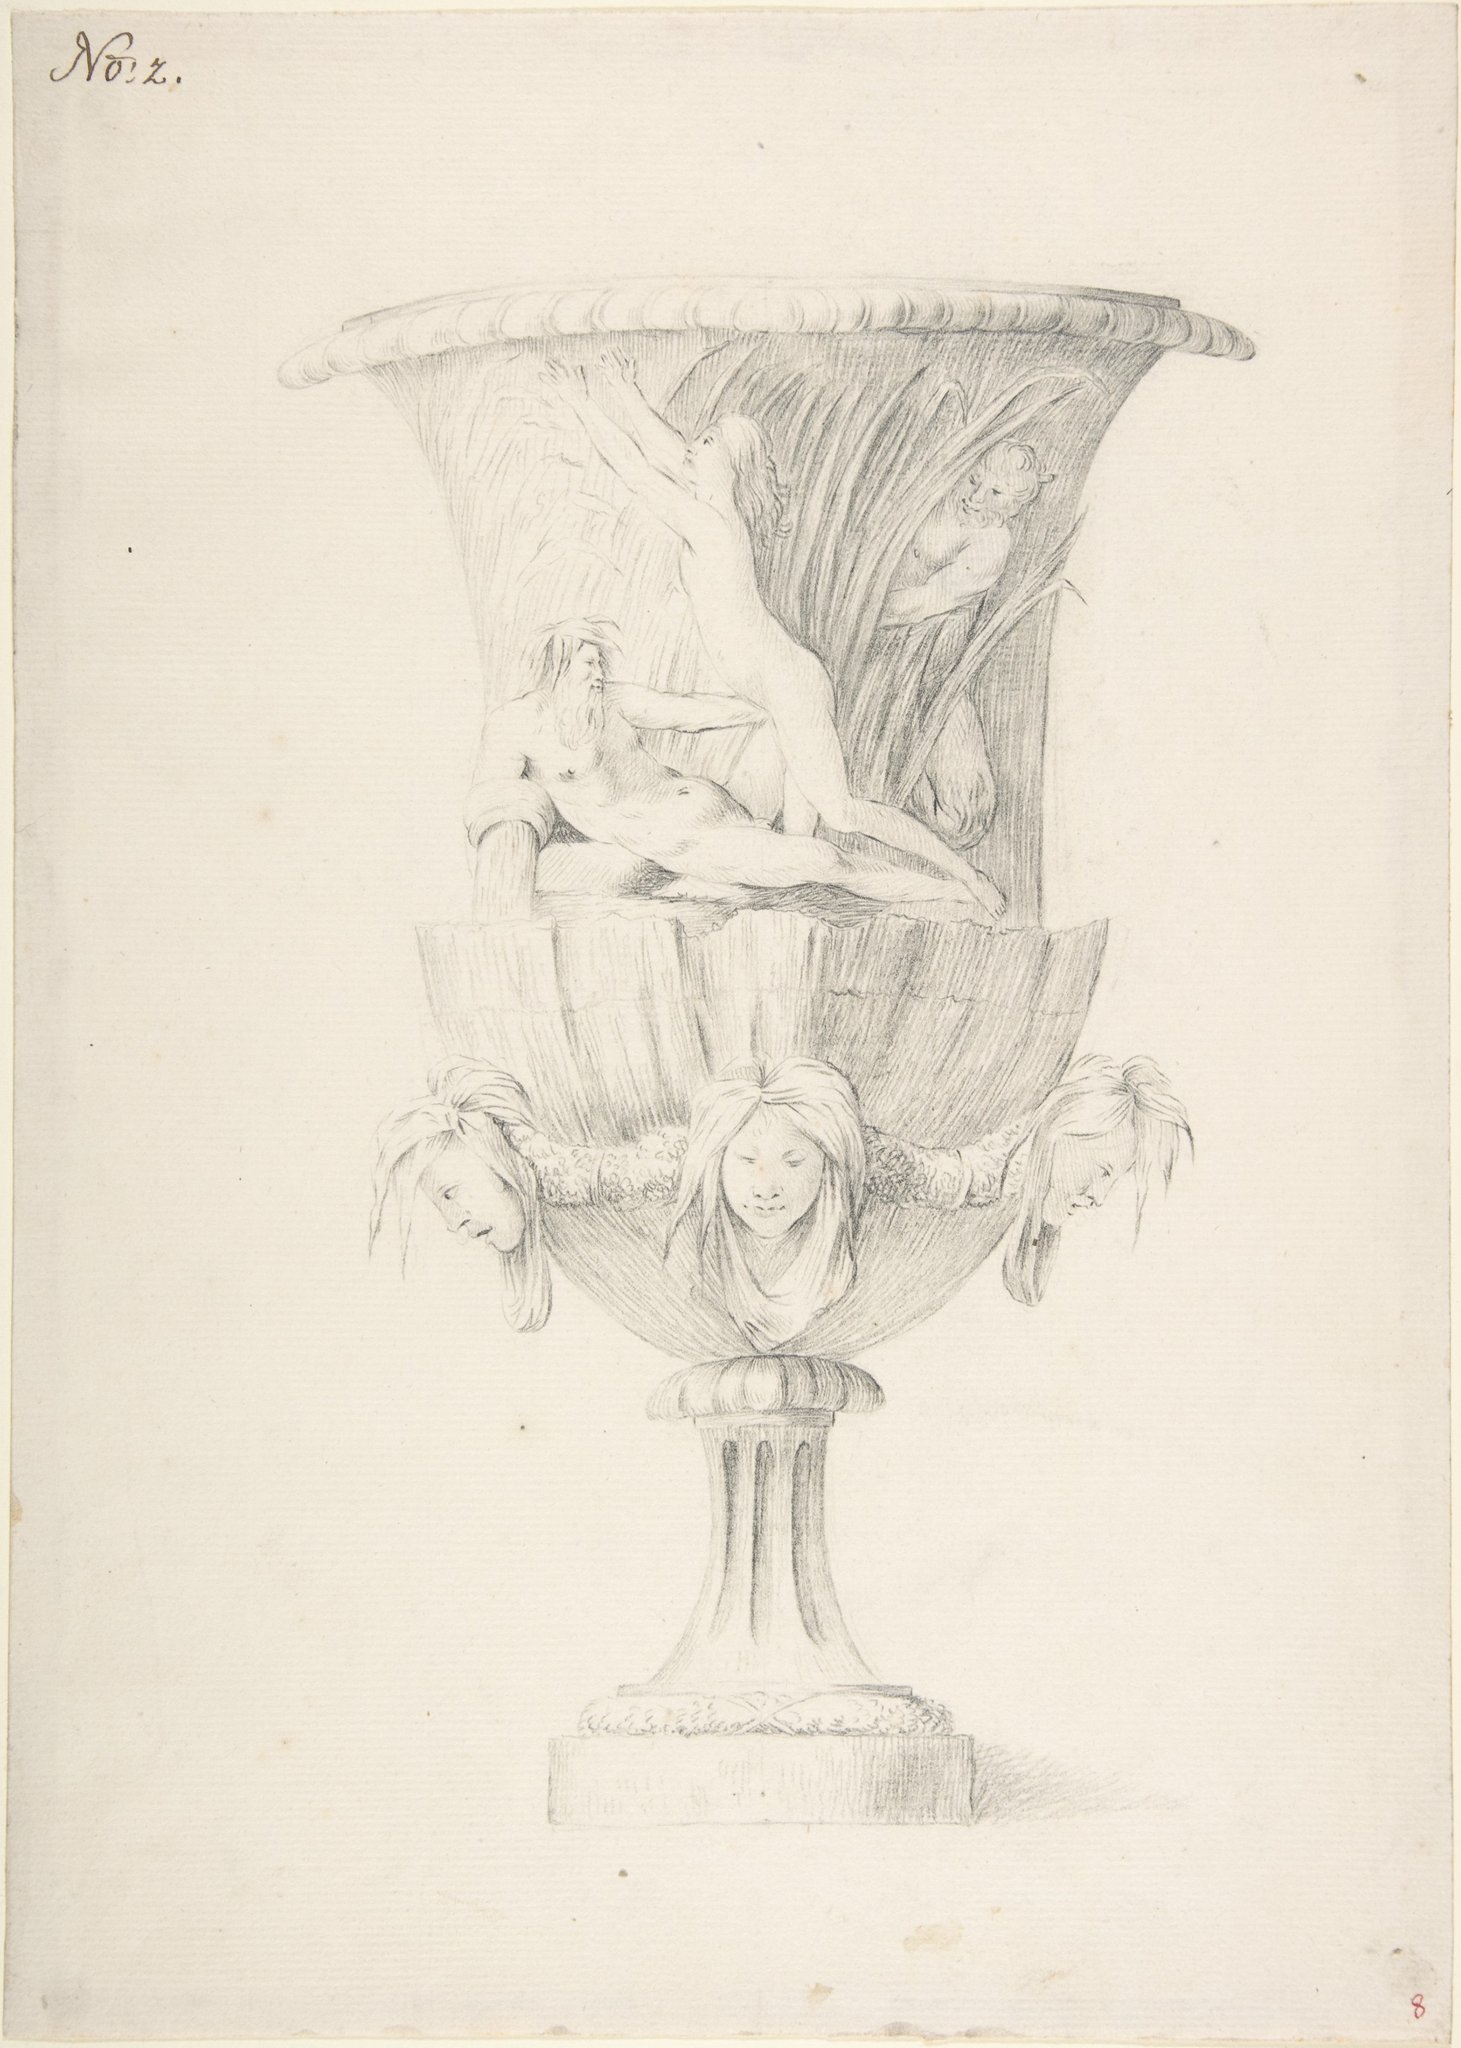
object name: drawing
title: Design for an Urn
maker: anonymous, french, 18th century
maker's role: artist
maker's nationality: french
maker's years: 1700-1800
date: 1770-1790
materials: graphite, ink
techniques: pen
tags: heads,women,urns